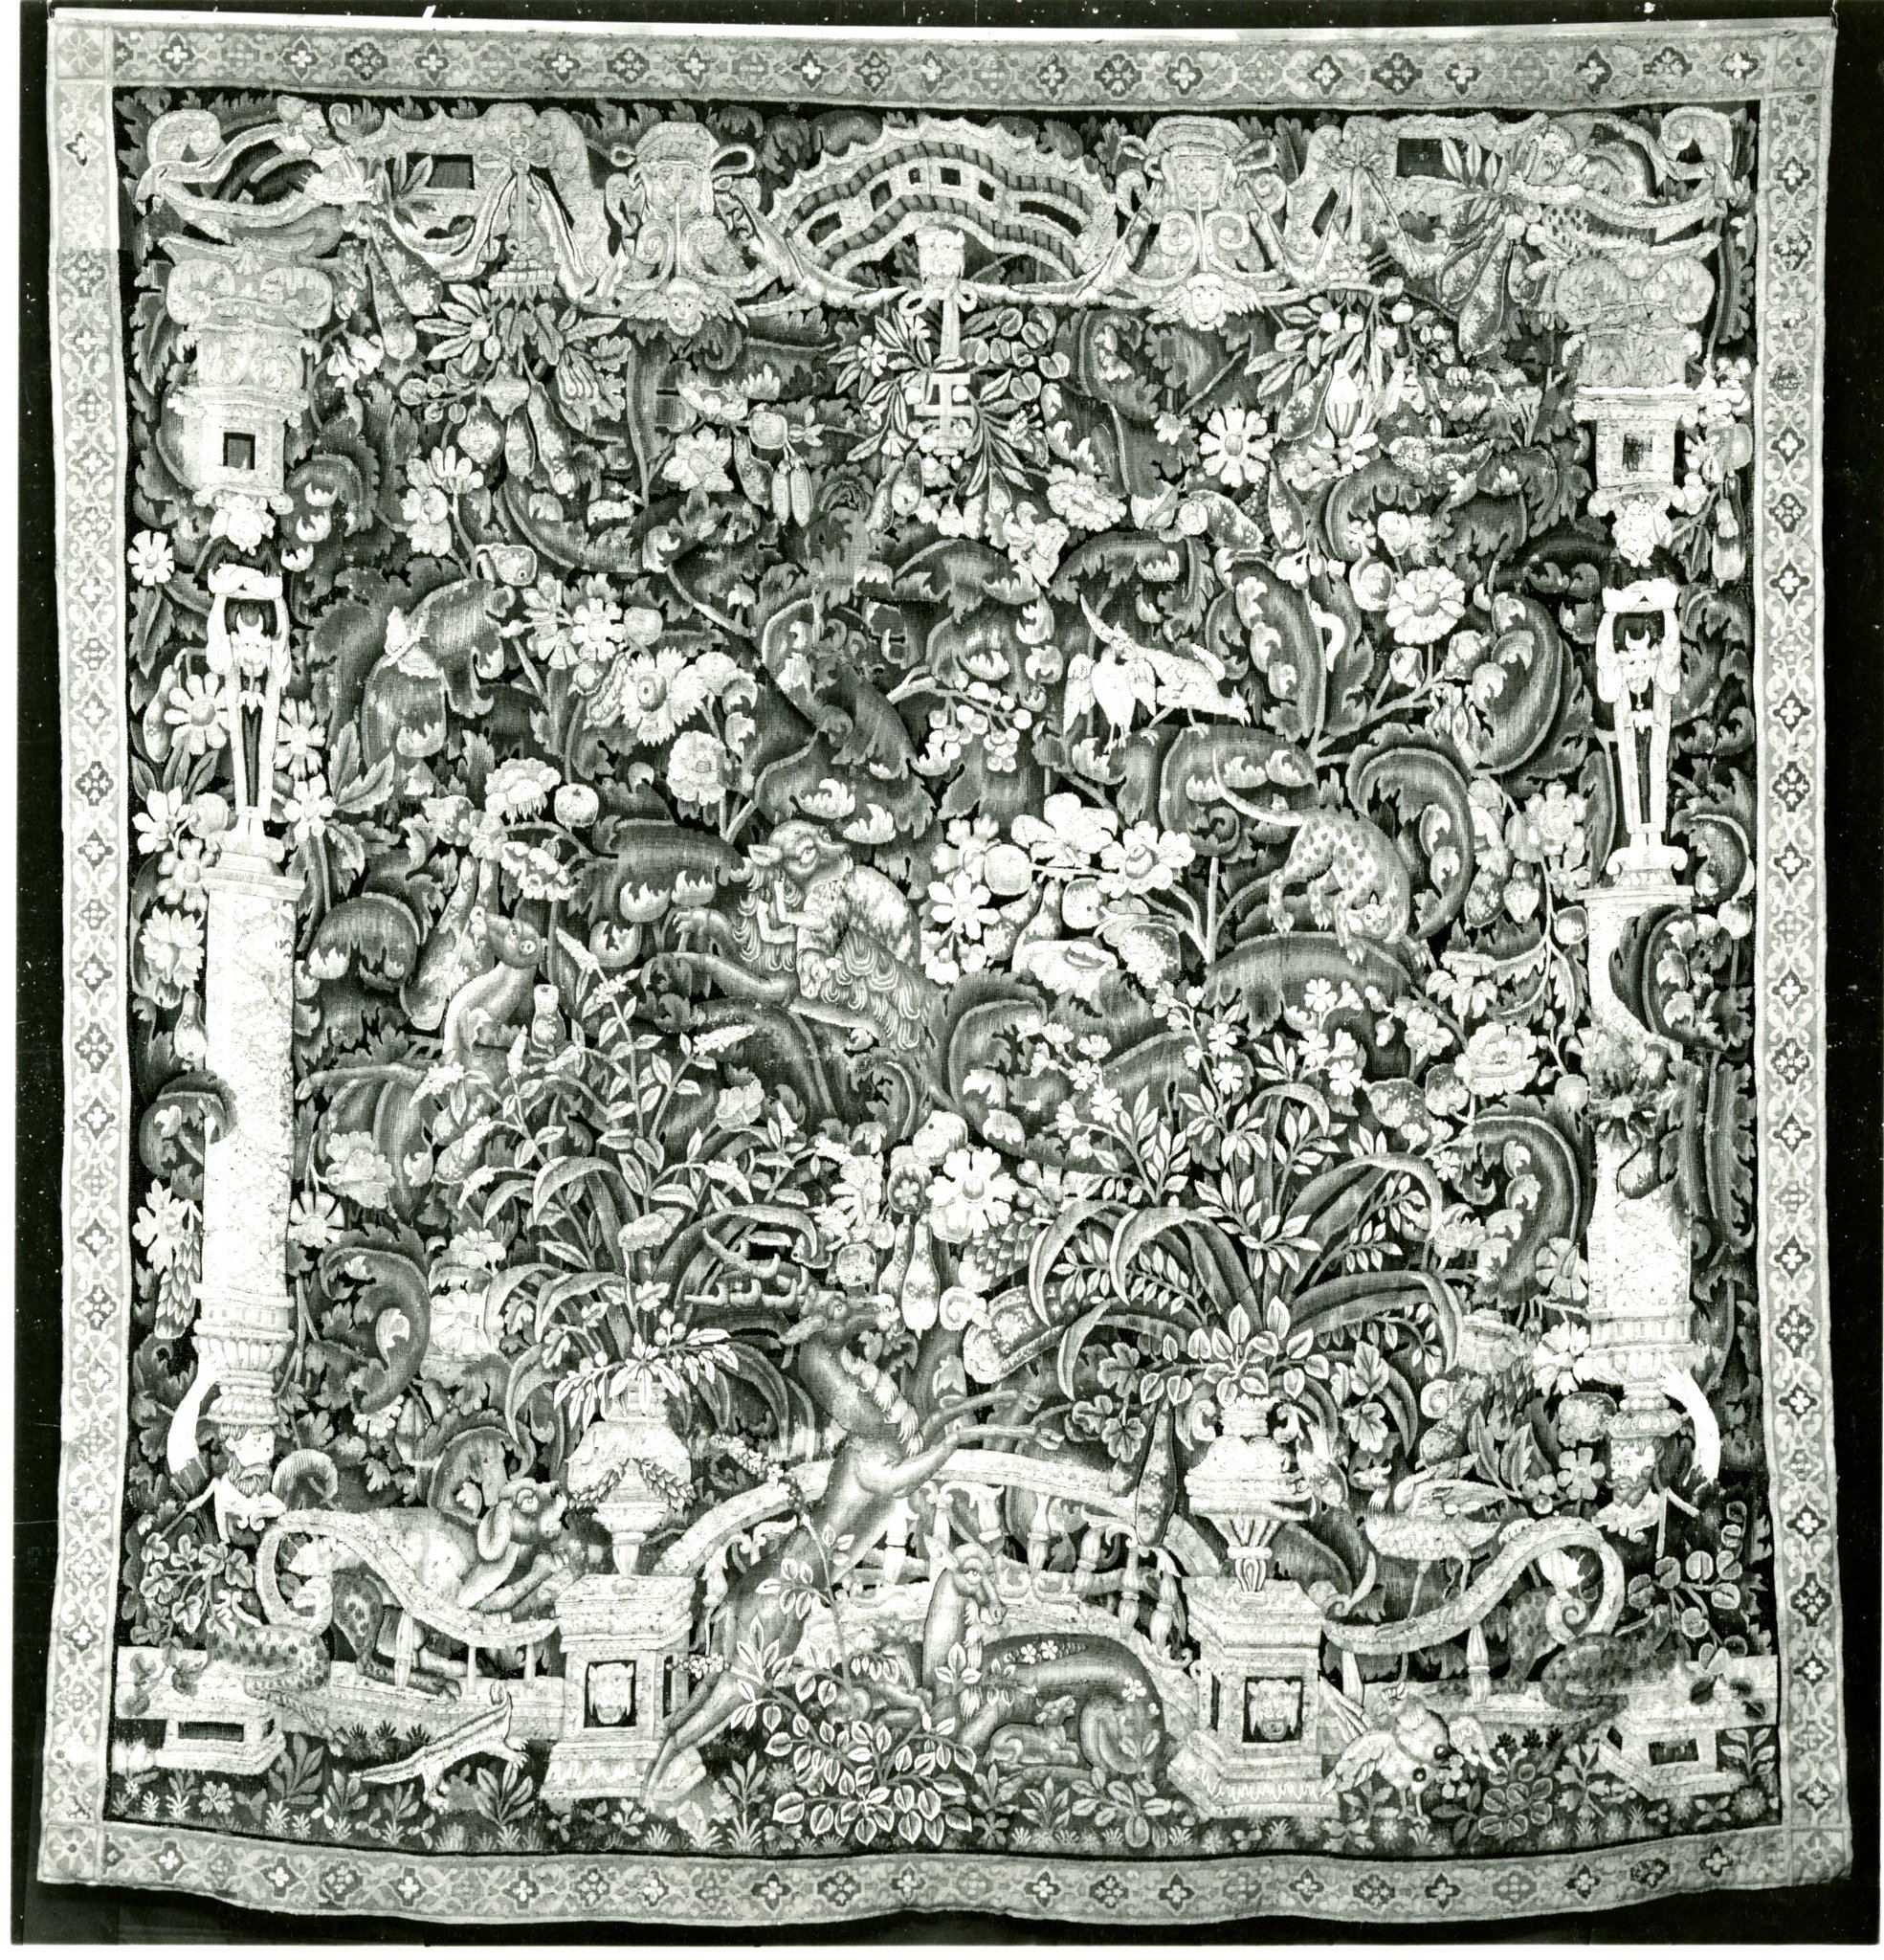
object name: tapestry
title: Thickets with Large Leaves, Flowers, Animals,...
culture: south netherlandish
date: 1540-1550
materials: silk, wool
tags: birds,deer,dogs,flowers